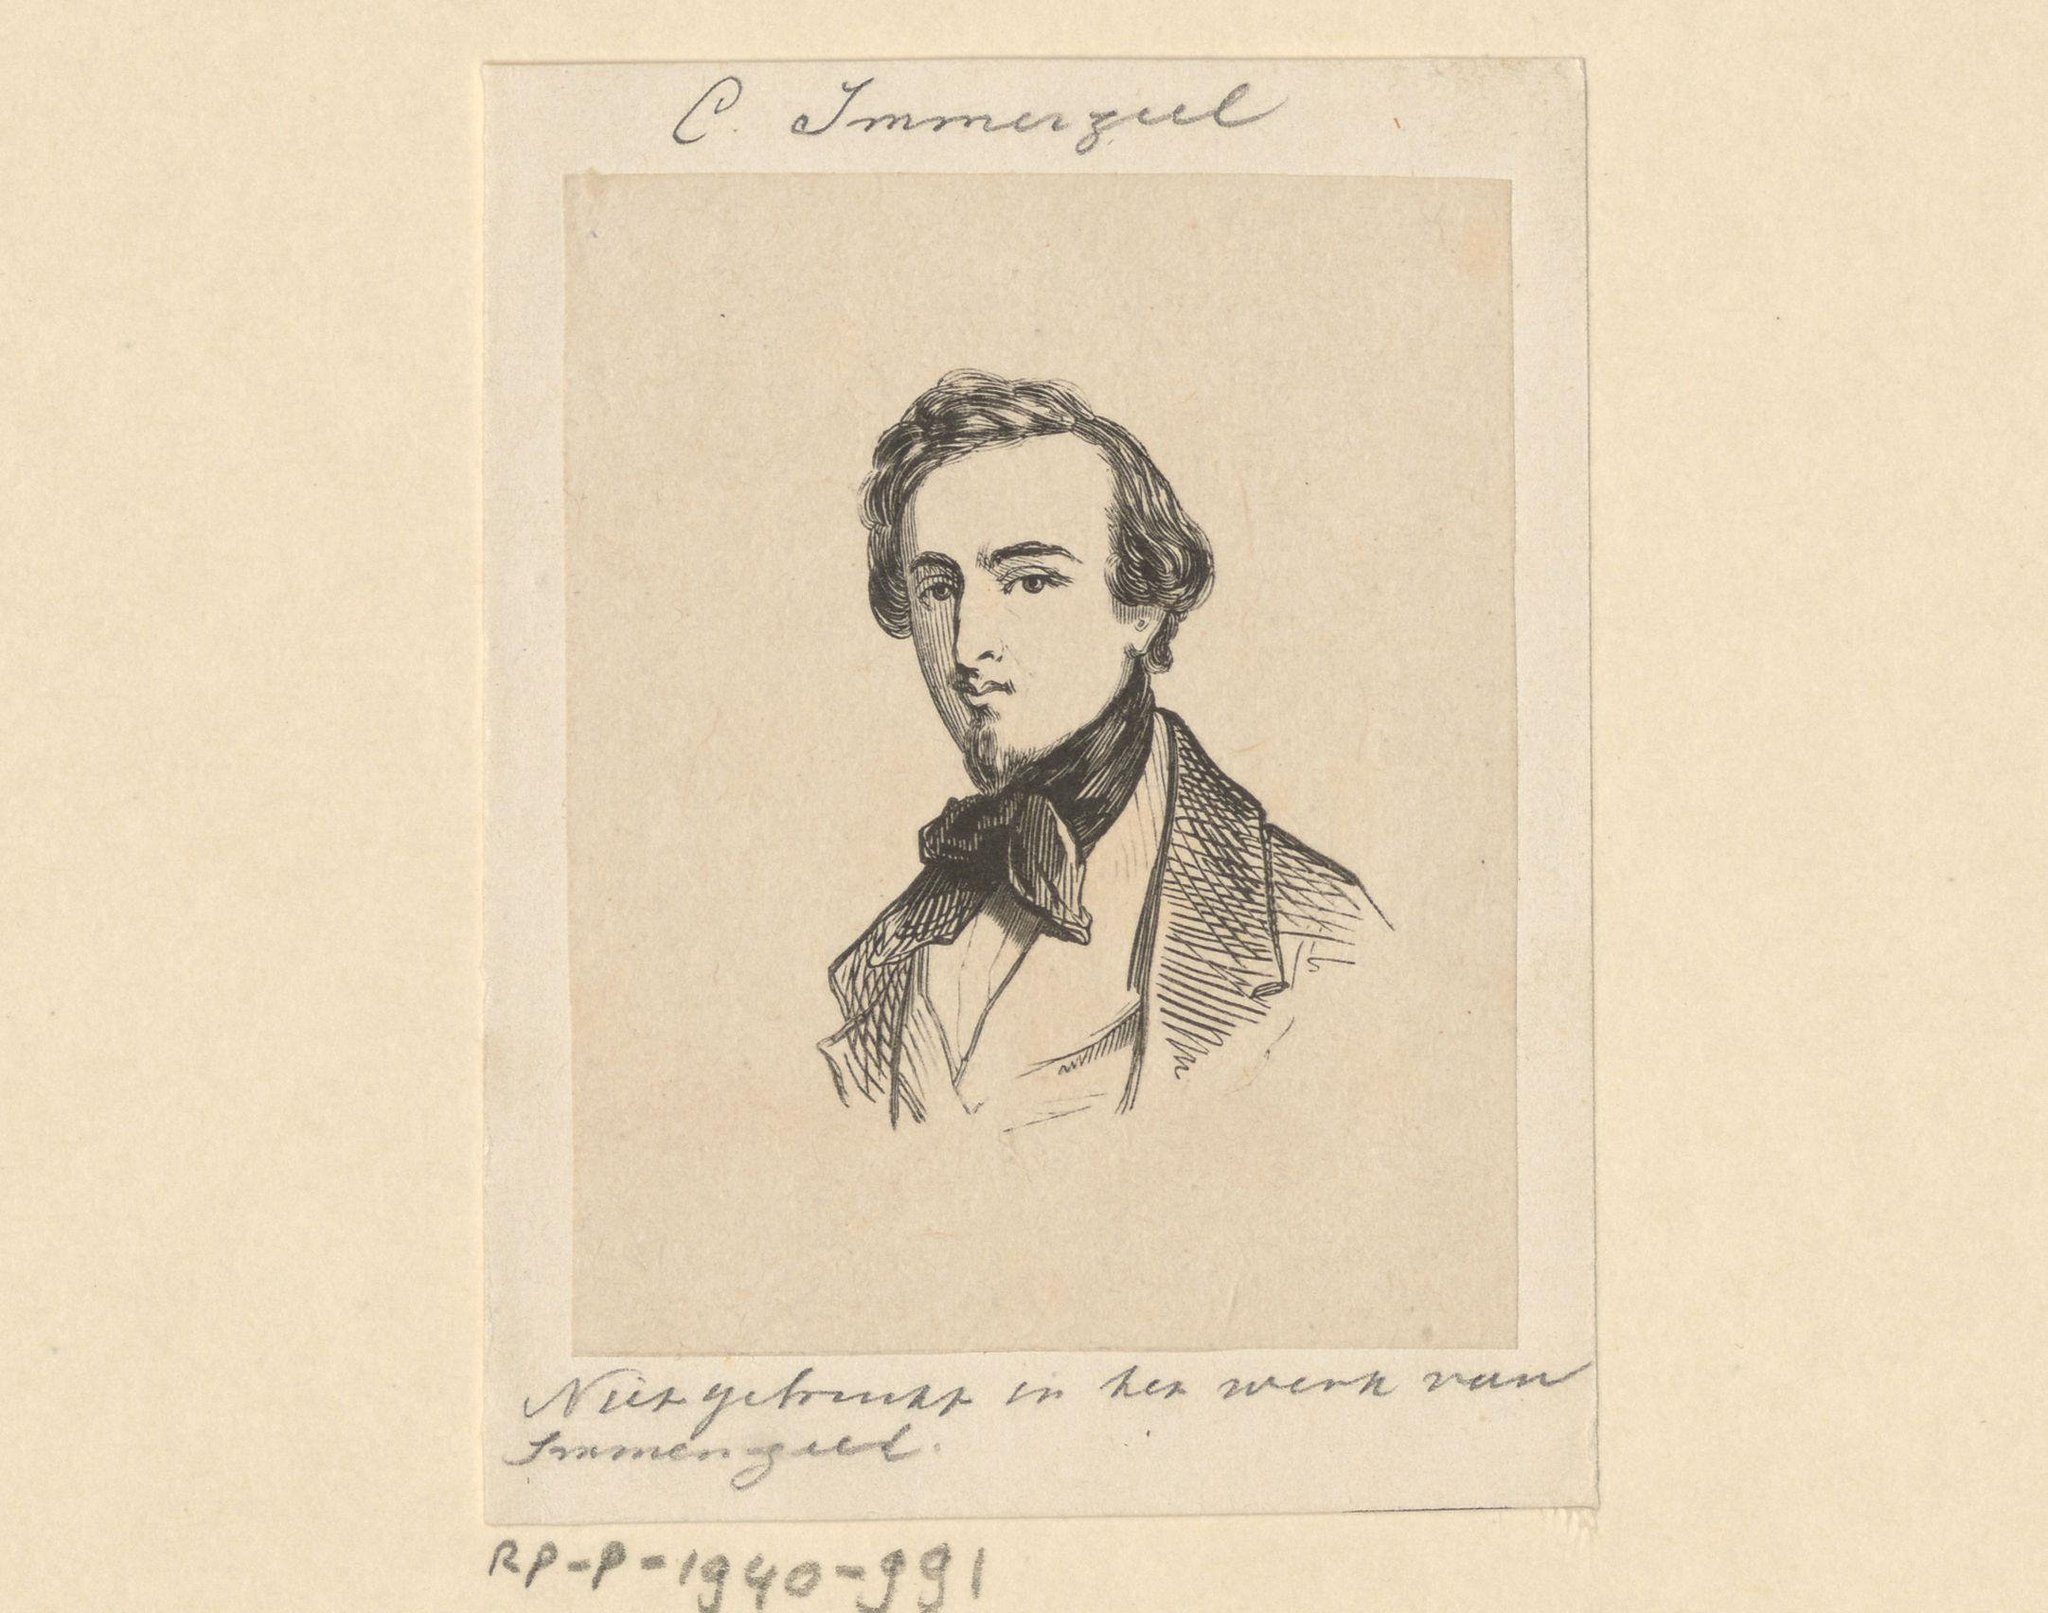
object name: print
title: Portret van Christiaan Immerzeel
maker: Anonymous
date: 1818-1886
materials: paper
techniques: engraving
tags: the hague, print maker, christiaan immerzeel, historical persons, portrait, self-portrait of artist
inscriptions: collector's mark: Lugt 2228, collector's mark: Lugt 2760